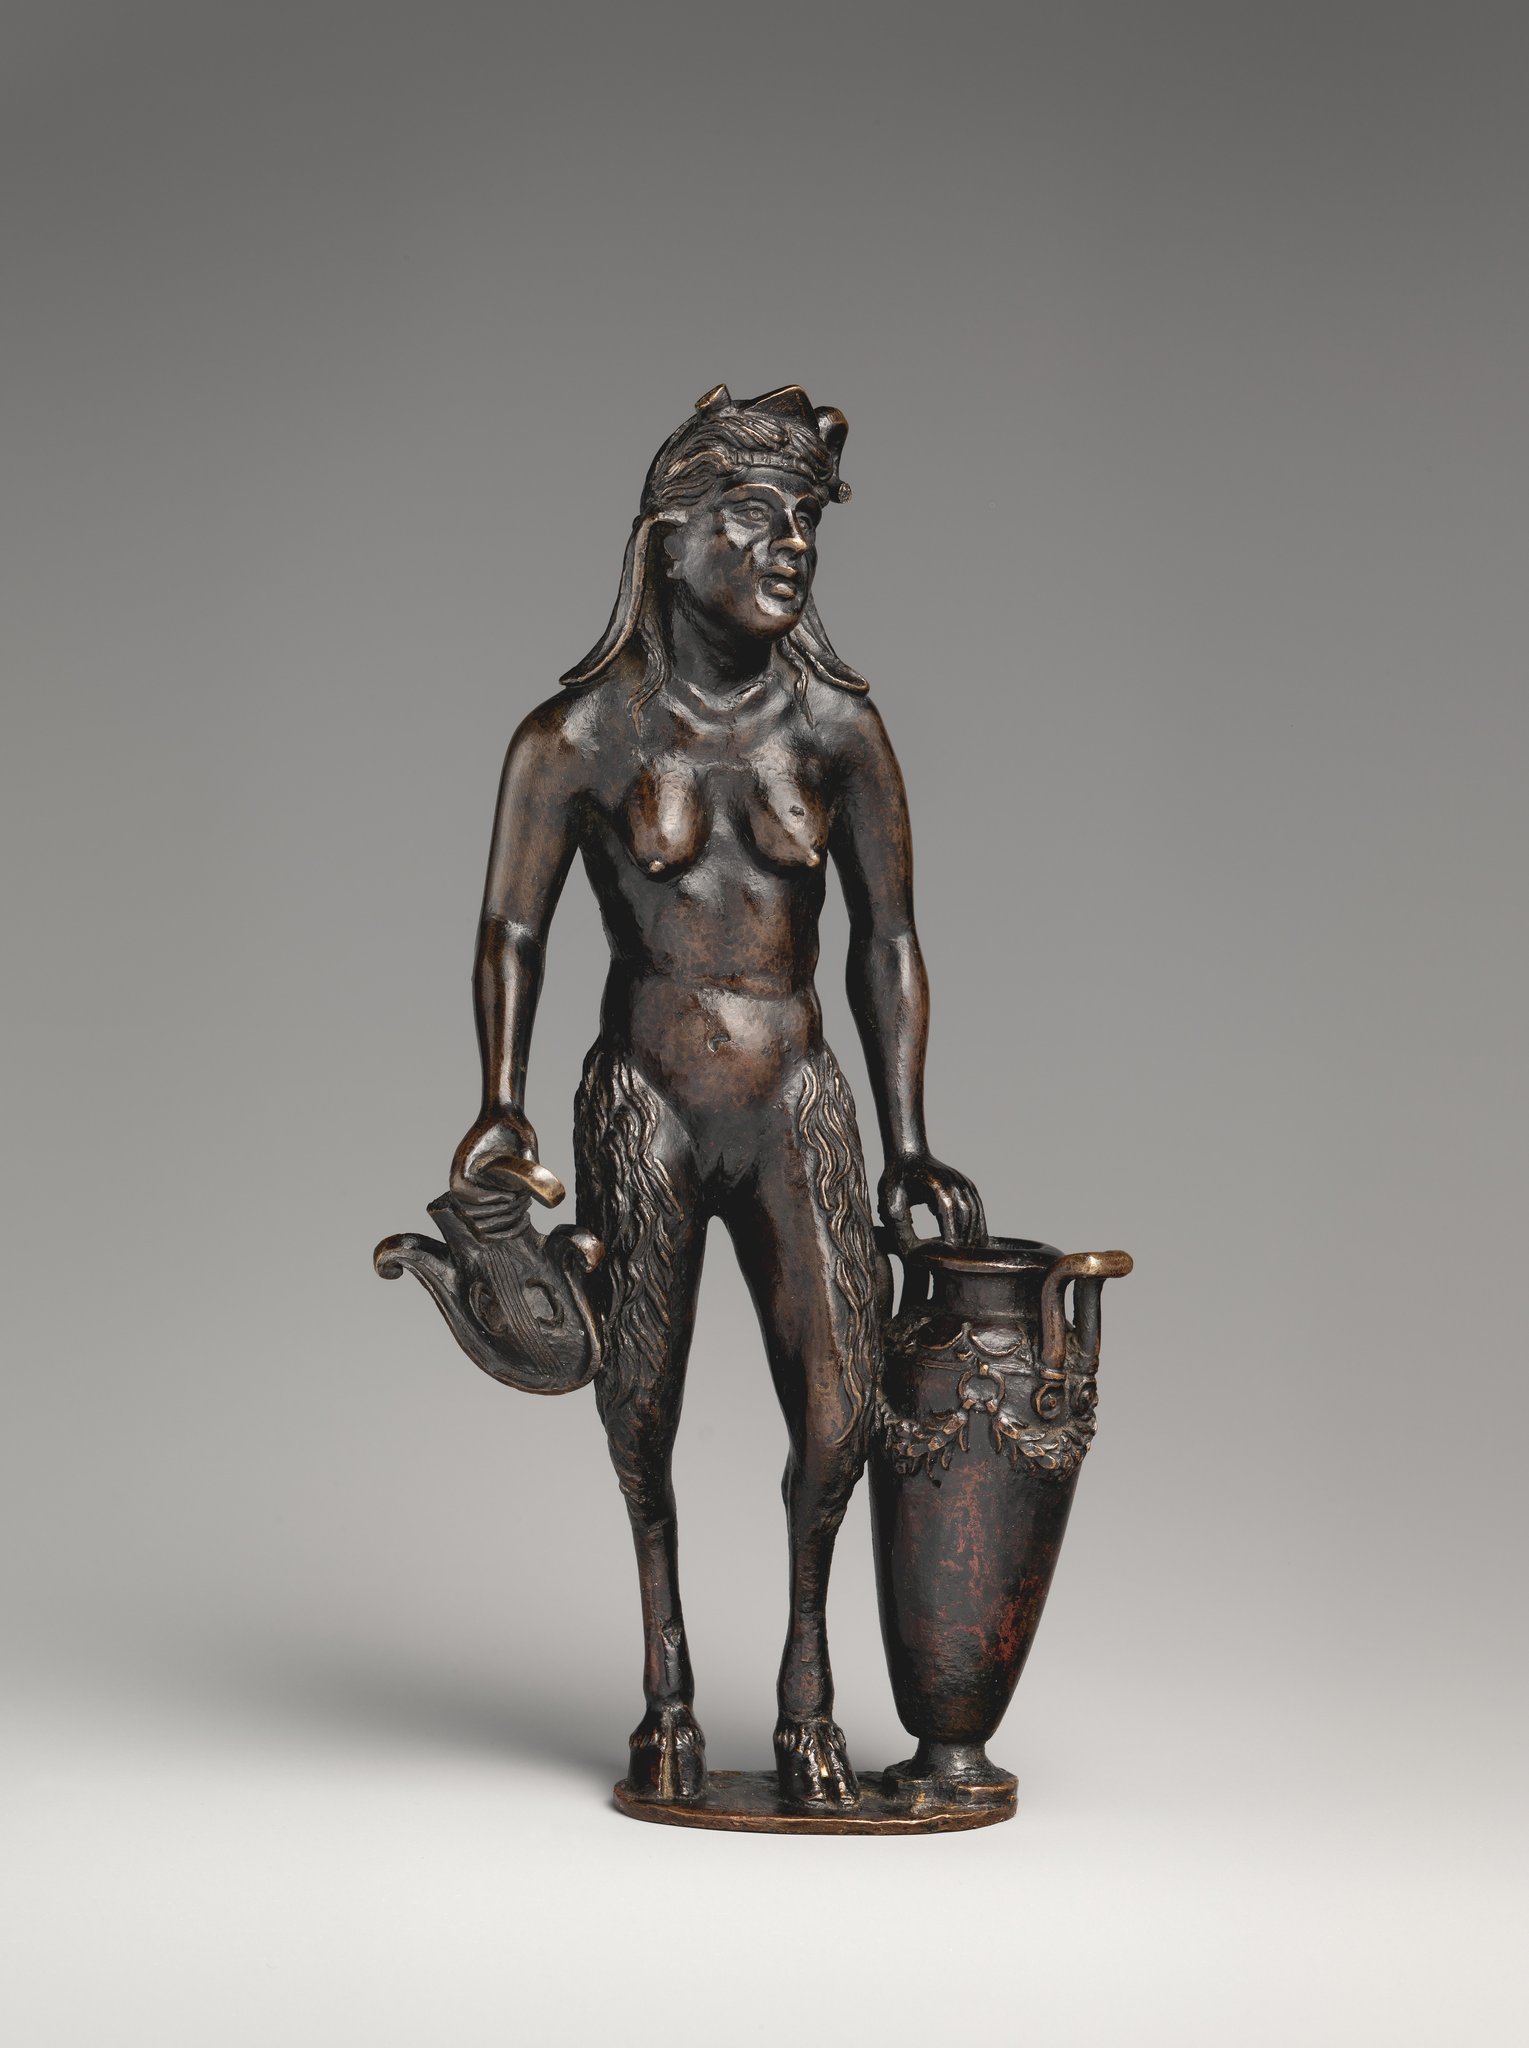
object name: statuette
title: Satyress with vase (one of a pair)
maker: andrea briosco, called riccio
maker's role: artist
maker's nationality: italian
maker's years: 1470-1532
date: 1540-1550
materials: bronze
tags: satyrs,urns